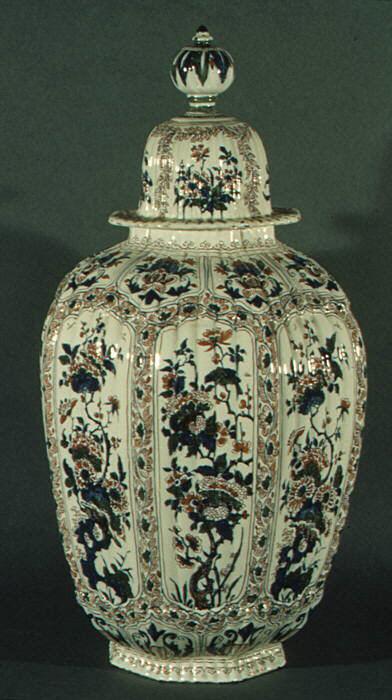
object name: vase with cover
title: Vase with cover (one of a pair)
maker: lambertus van eenhoorn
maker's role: artist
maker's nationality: dutch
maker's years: 1651-1721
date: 1700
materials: earthenware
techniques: glazing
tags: flowers